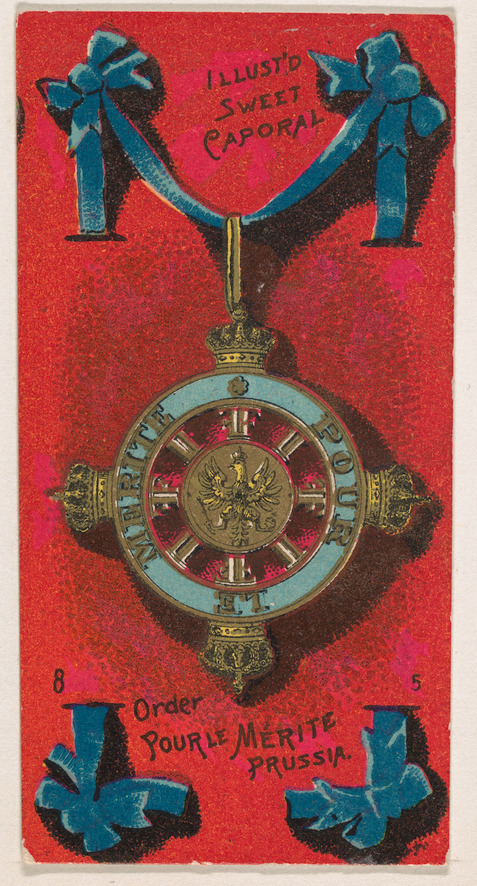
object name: print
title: Order Pour le Merite, Prussia, from the Military Series (N224) issued by Kinney Tobacco Company to promote Sweet Caporal Cigarettes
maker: kinney brothers tobacco company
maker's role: publisher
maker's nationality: american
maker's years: 1869-2011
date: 1888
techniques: color lithograph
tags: insignia